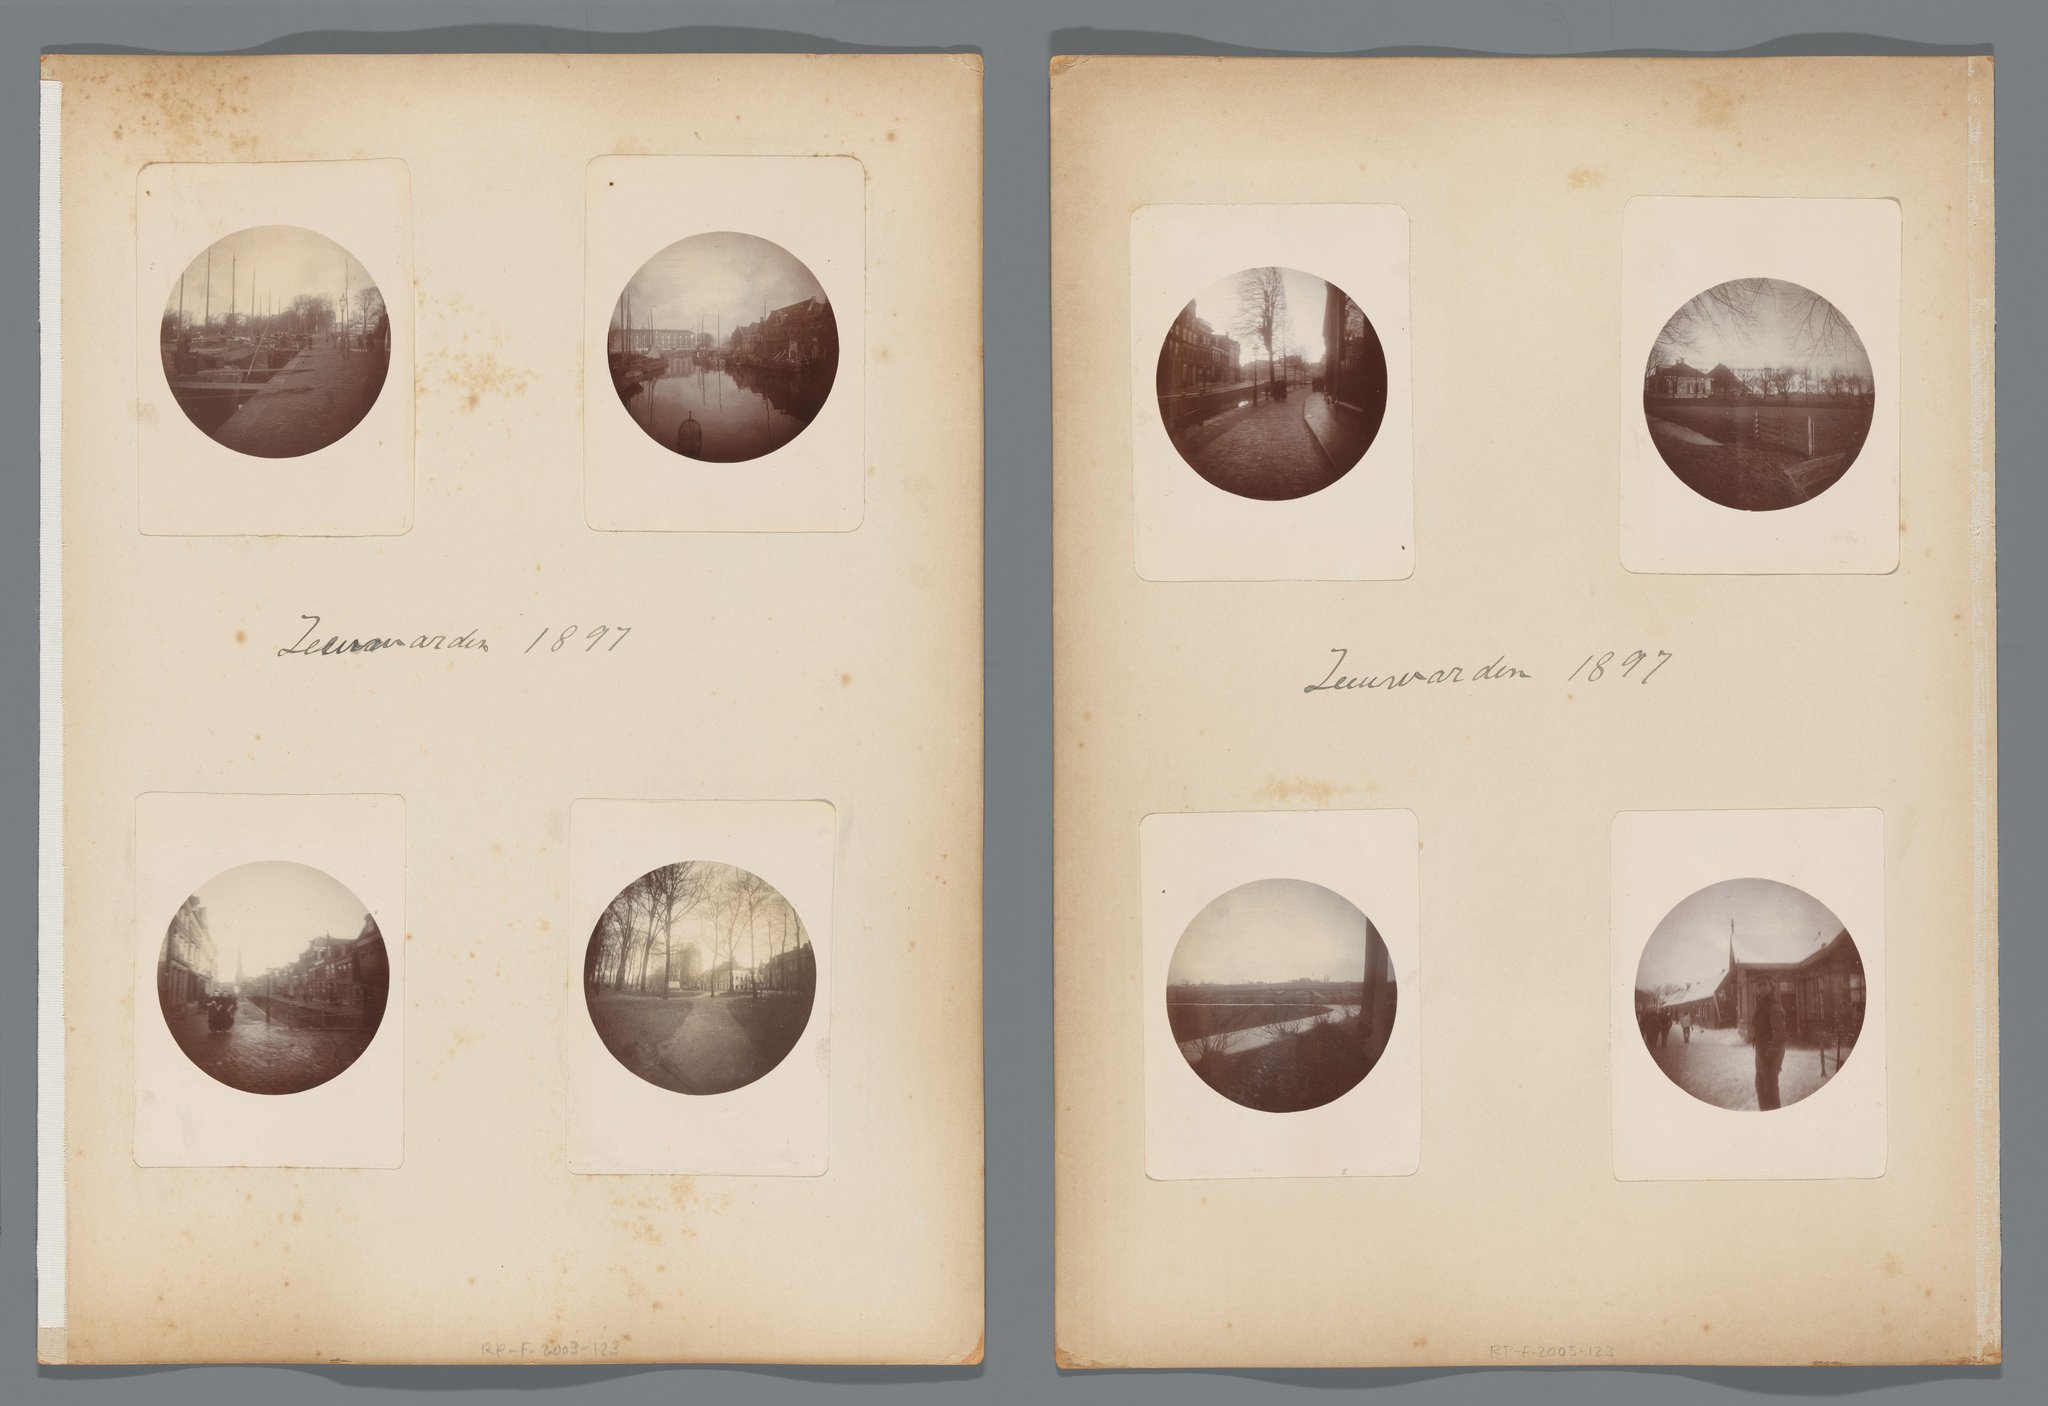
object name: photograph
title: Albumblad met acht ronde Kodak-foto's in en om Leeuwarden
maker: Anonymous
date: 1897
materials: paper, cardboard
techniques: gelatin silver print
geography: leeuwarden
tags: city-view in general; 'veduta'